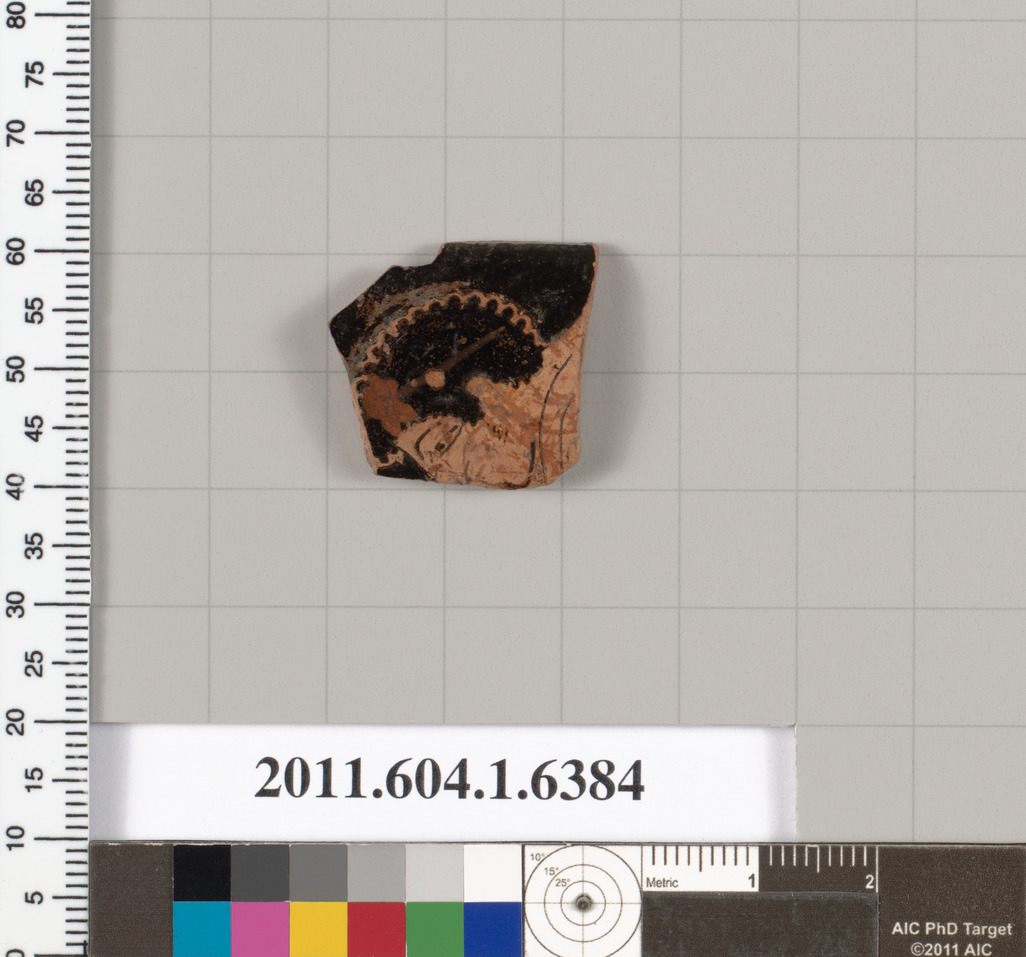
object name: kylix fragment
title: Terracotta rim fragment of a kylix (drinking cup)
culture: greek, attic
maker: antiphon painter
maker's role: artist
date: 490-480 BCE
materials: terracotta